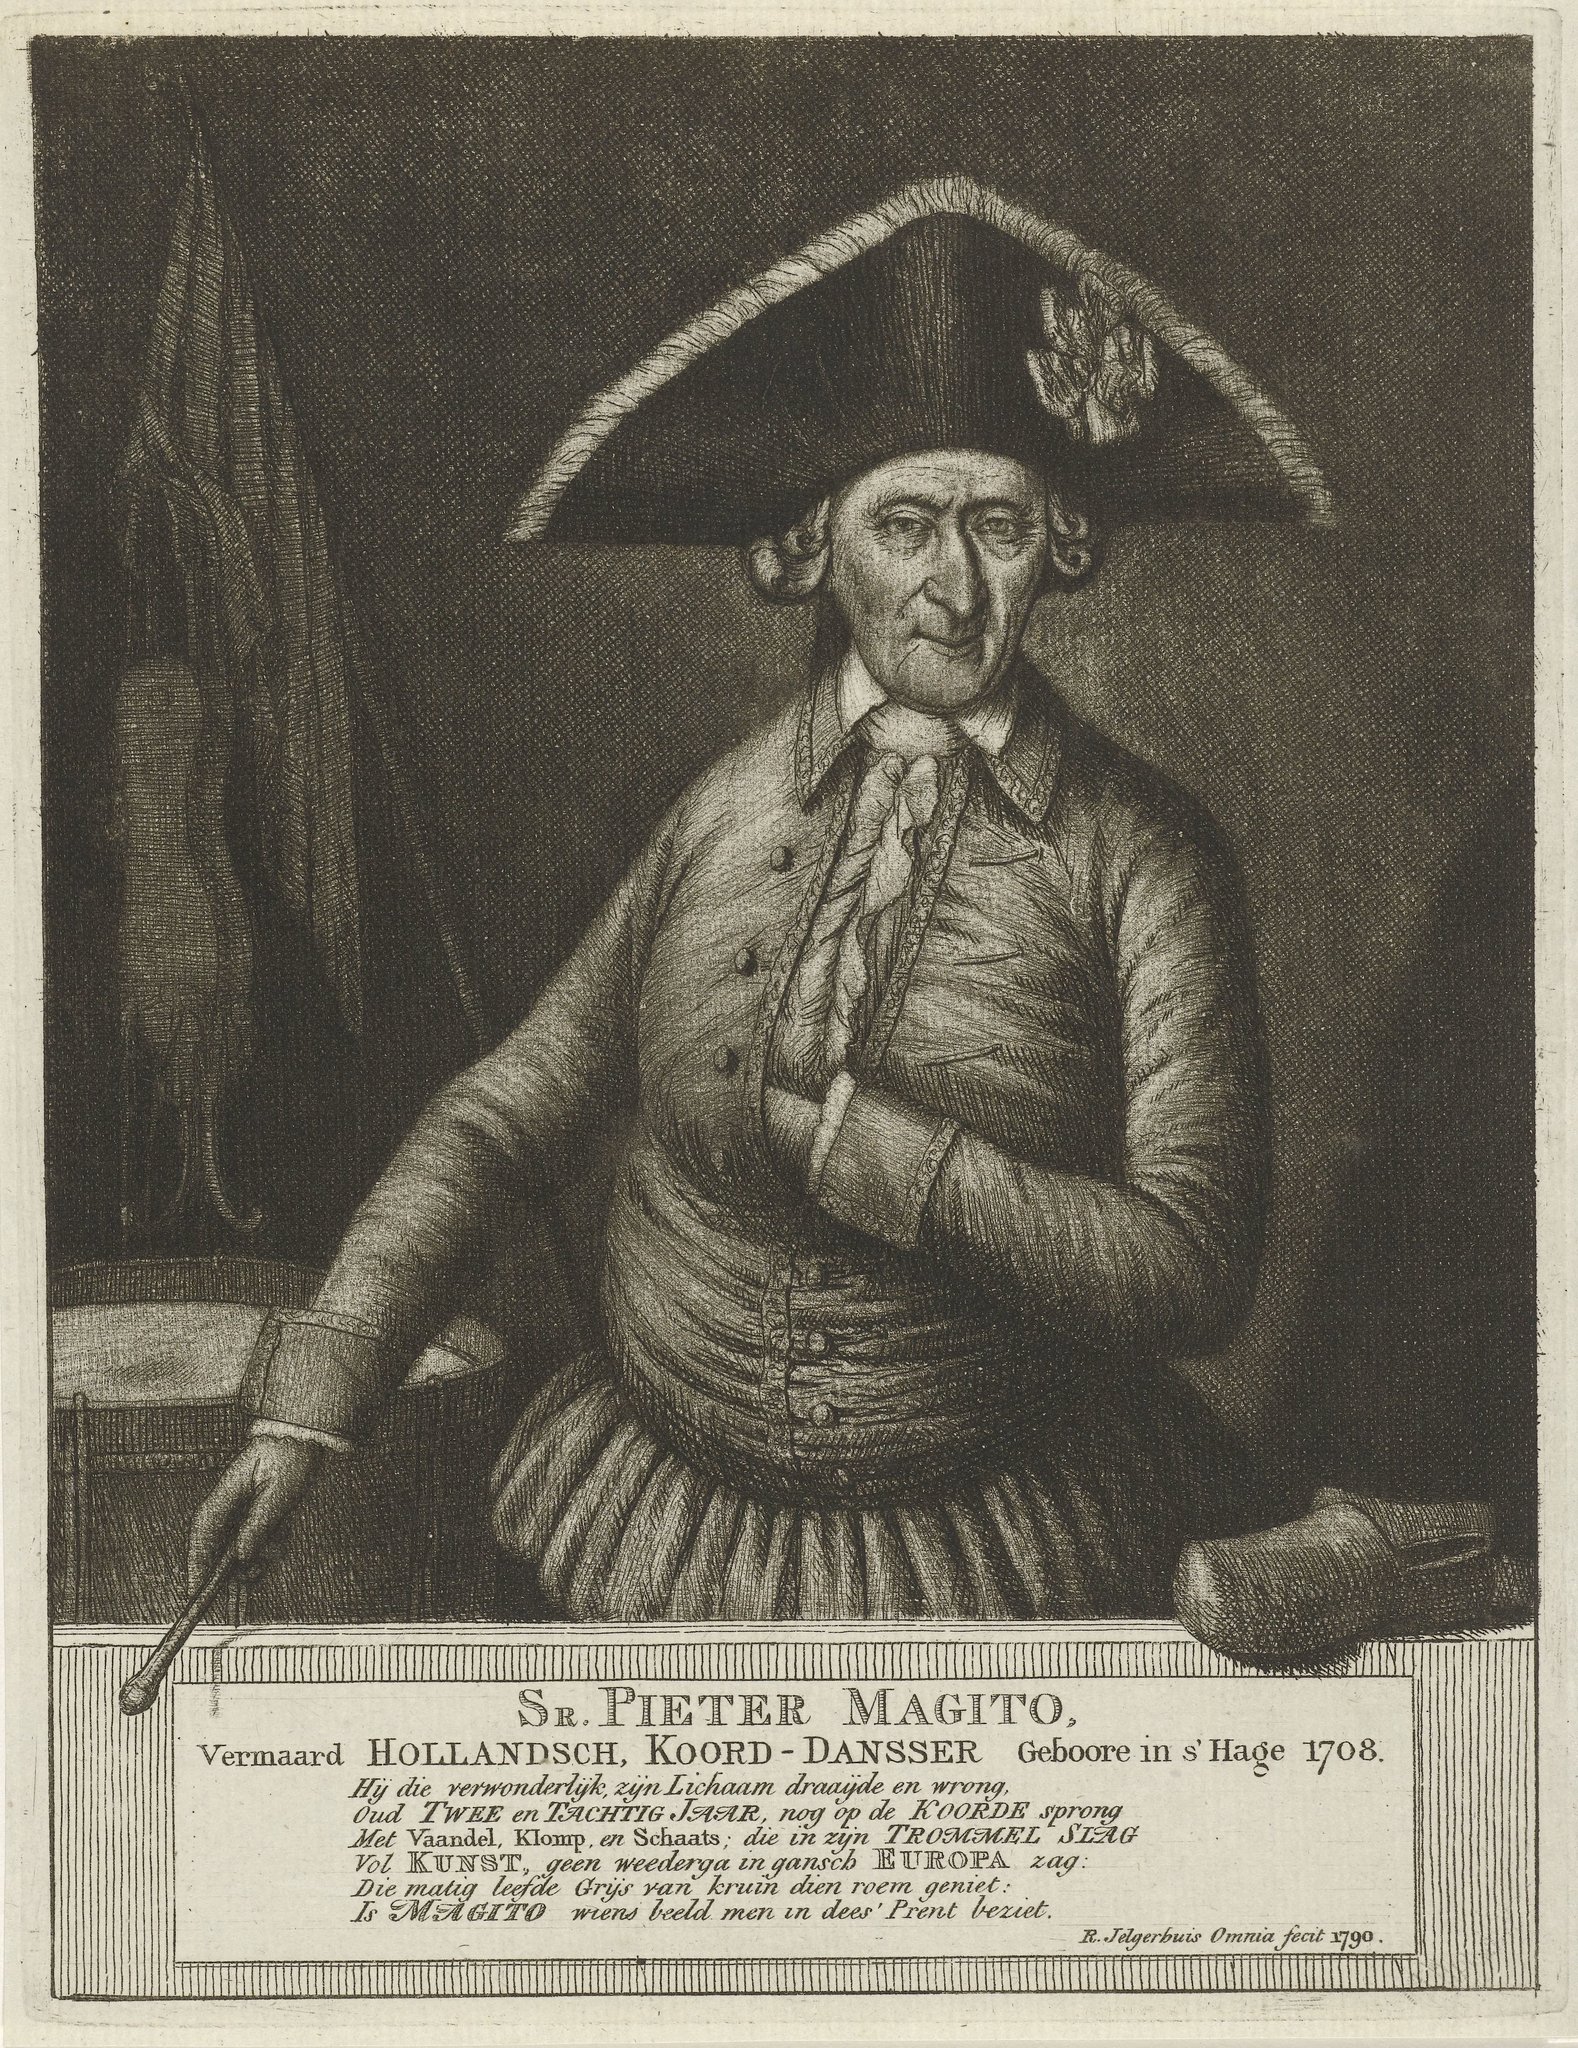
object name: print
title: Portret van Pieter Magito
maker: rienk jelgerhuis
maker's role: draughtsman, print maker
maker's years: 1729-1806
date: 1790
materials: paper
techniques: etching, sugar lift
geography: leeuwarden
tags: wooden shoes, clogs, drum (musical instrument)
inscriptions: collector's mark: Lugt 2228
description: Portret van de koorddanser Pieter Magito, met trommel, klompen en schaatsen. In het kader onder zijn portret zijn naam en beroep en een zesregelig gedicht in het Nederlands.